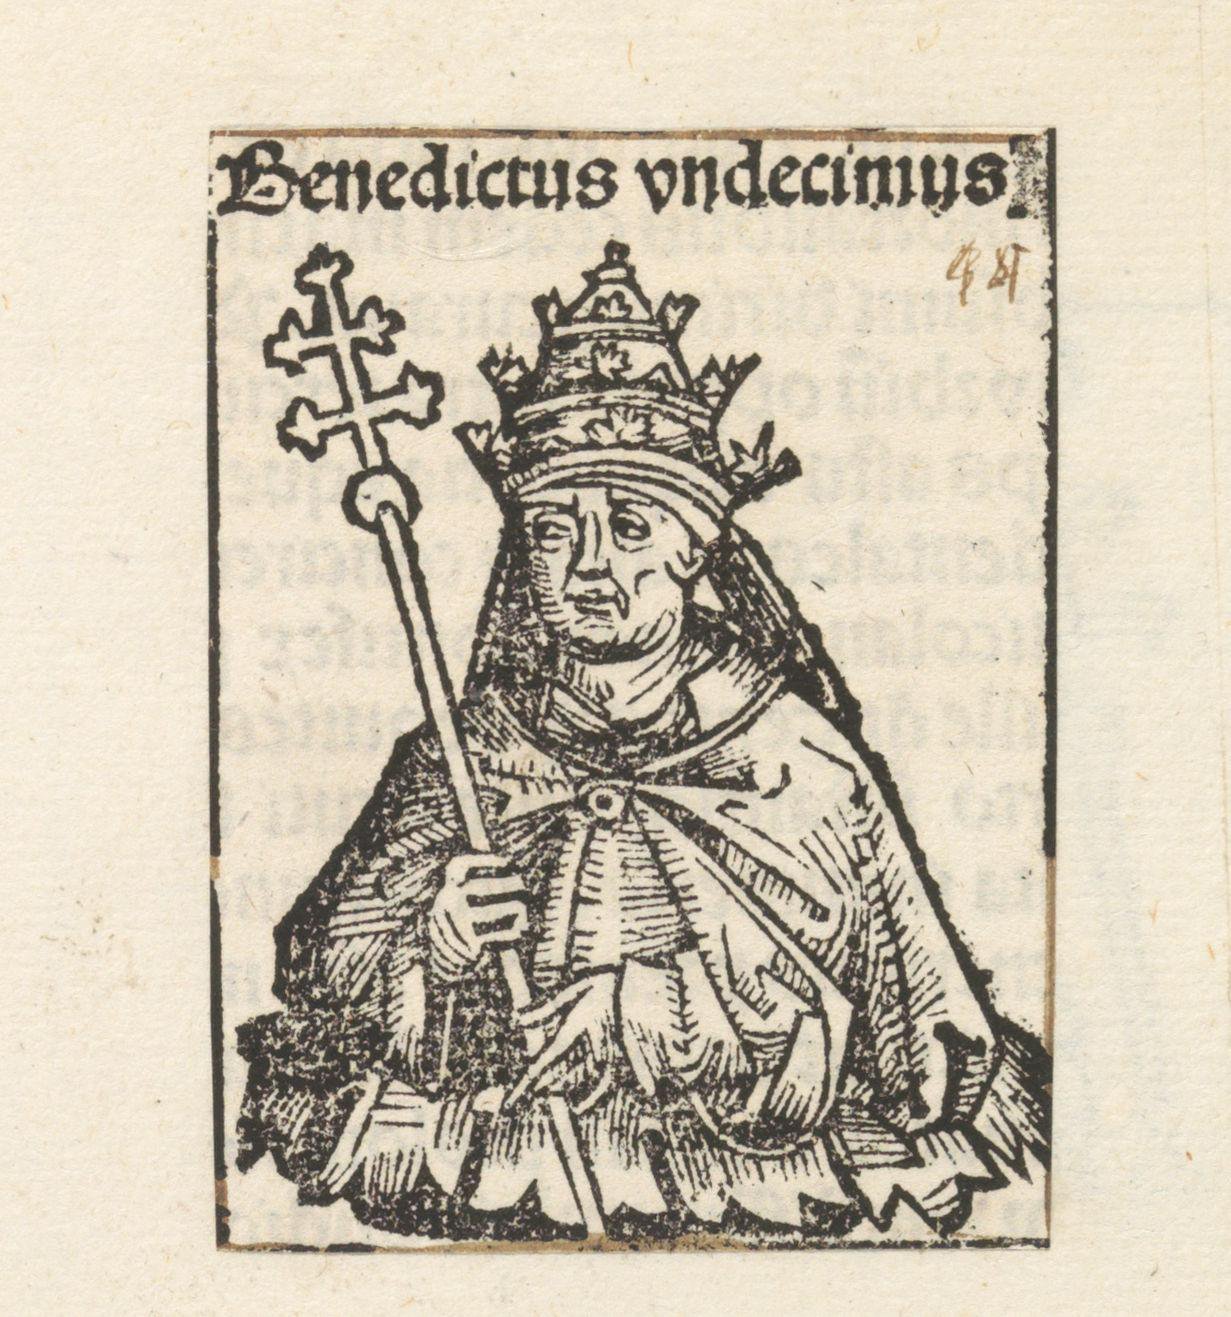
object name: print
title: Benedictus undecimus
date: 1493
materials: paper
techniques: letterpress printing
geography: nuremberg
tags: pope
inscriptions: inscription: ‘44’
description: Een bloemkelk met een paus. Hij draagt een tiara en heeft een staf met een dubbel kruis in zijn handen. De voorstelling is onderdeel van de opeenvolging pausen in de Liber Chronicarum. De tekst identificeert de man als Benedictus XI. De prent maakt deel uit van een album.